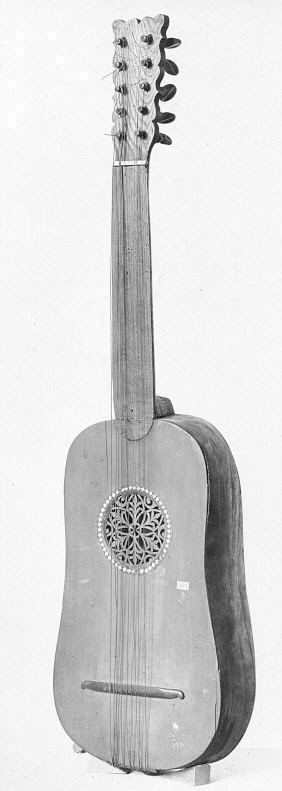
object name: chitarra battente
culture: italian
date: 1801-1900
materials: metal, wood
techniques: inlay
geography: italy